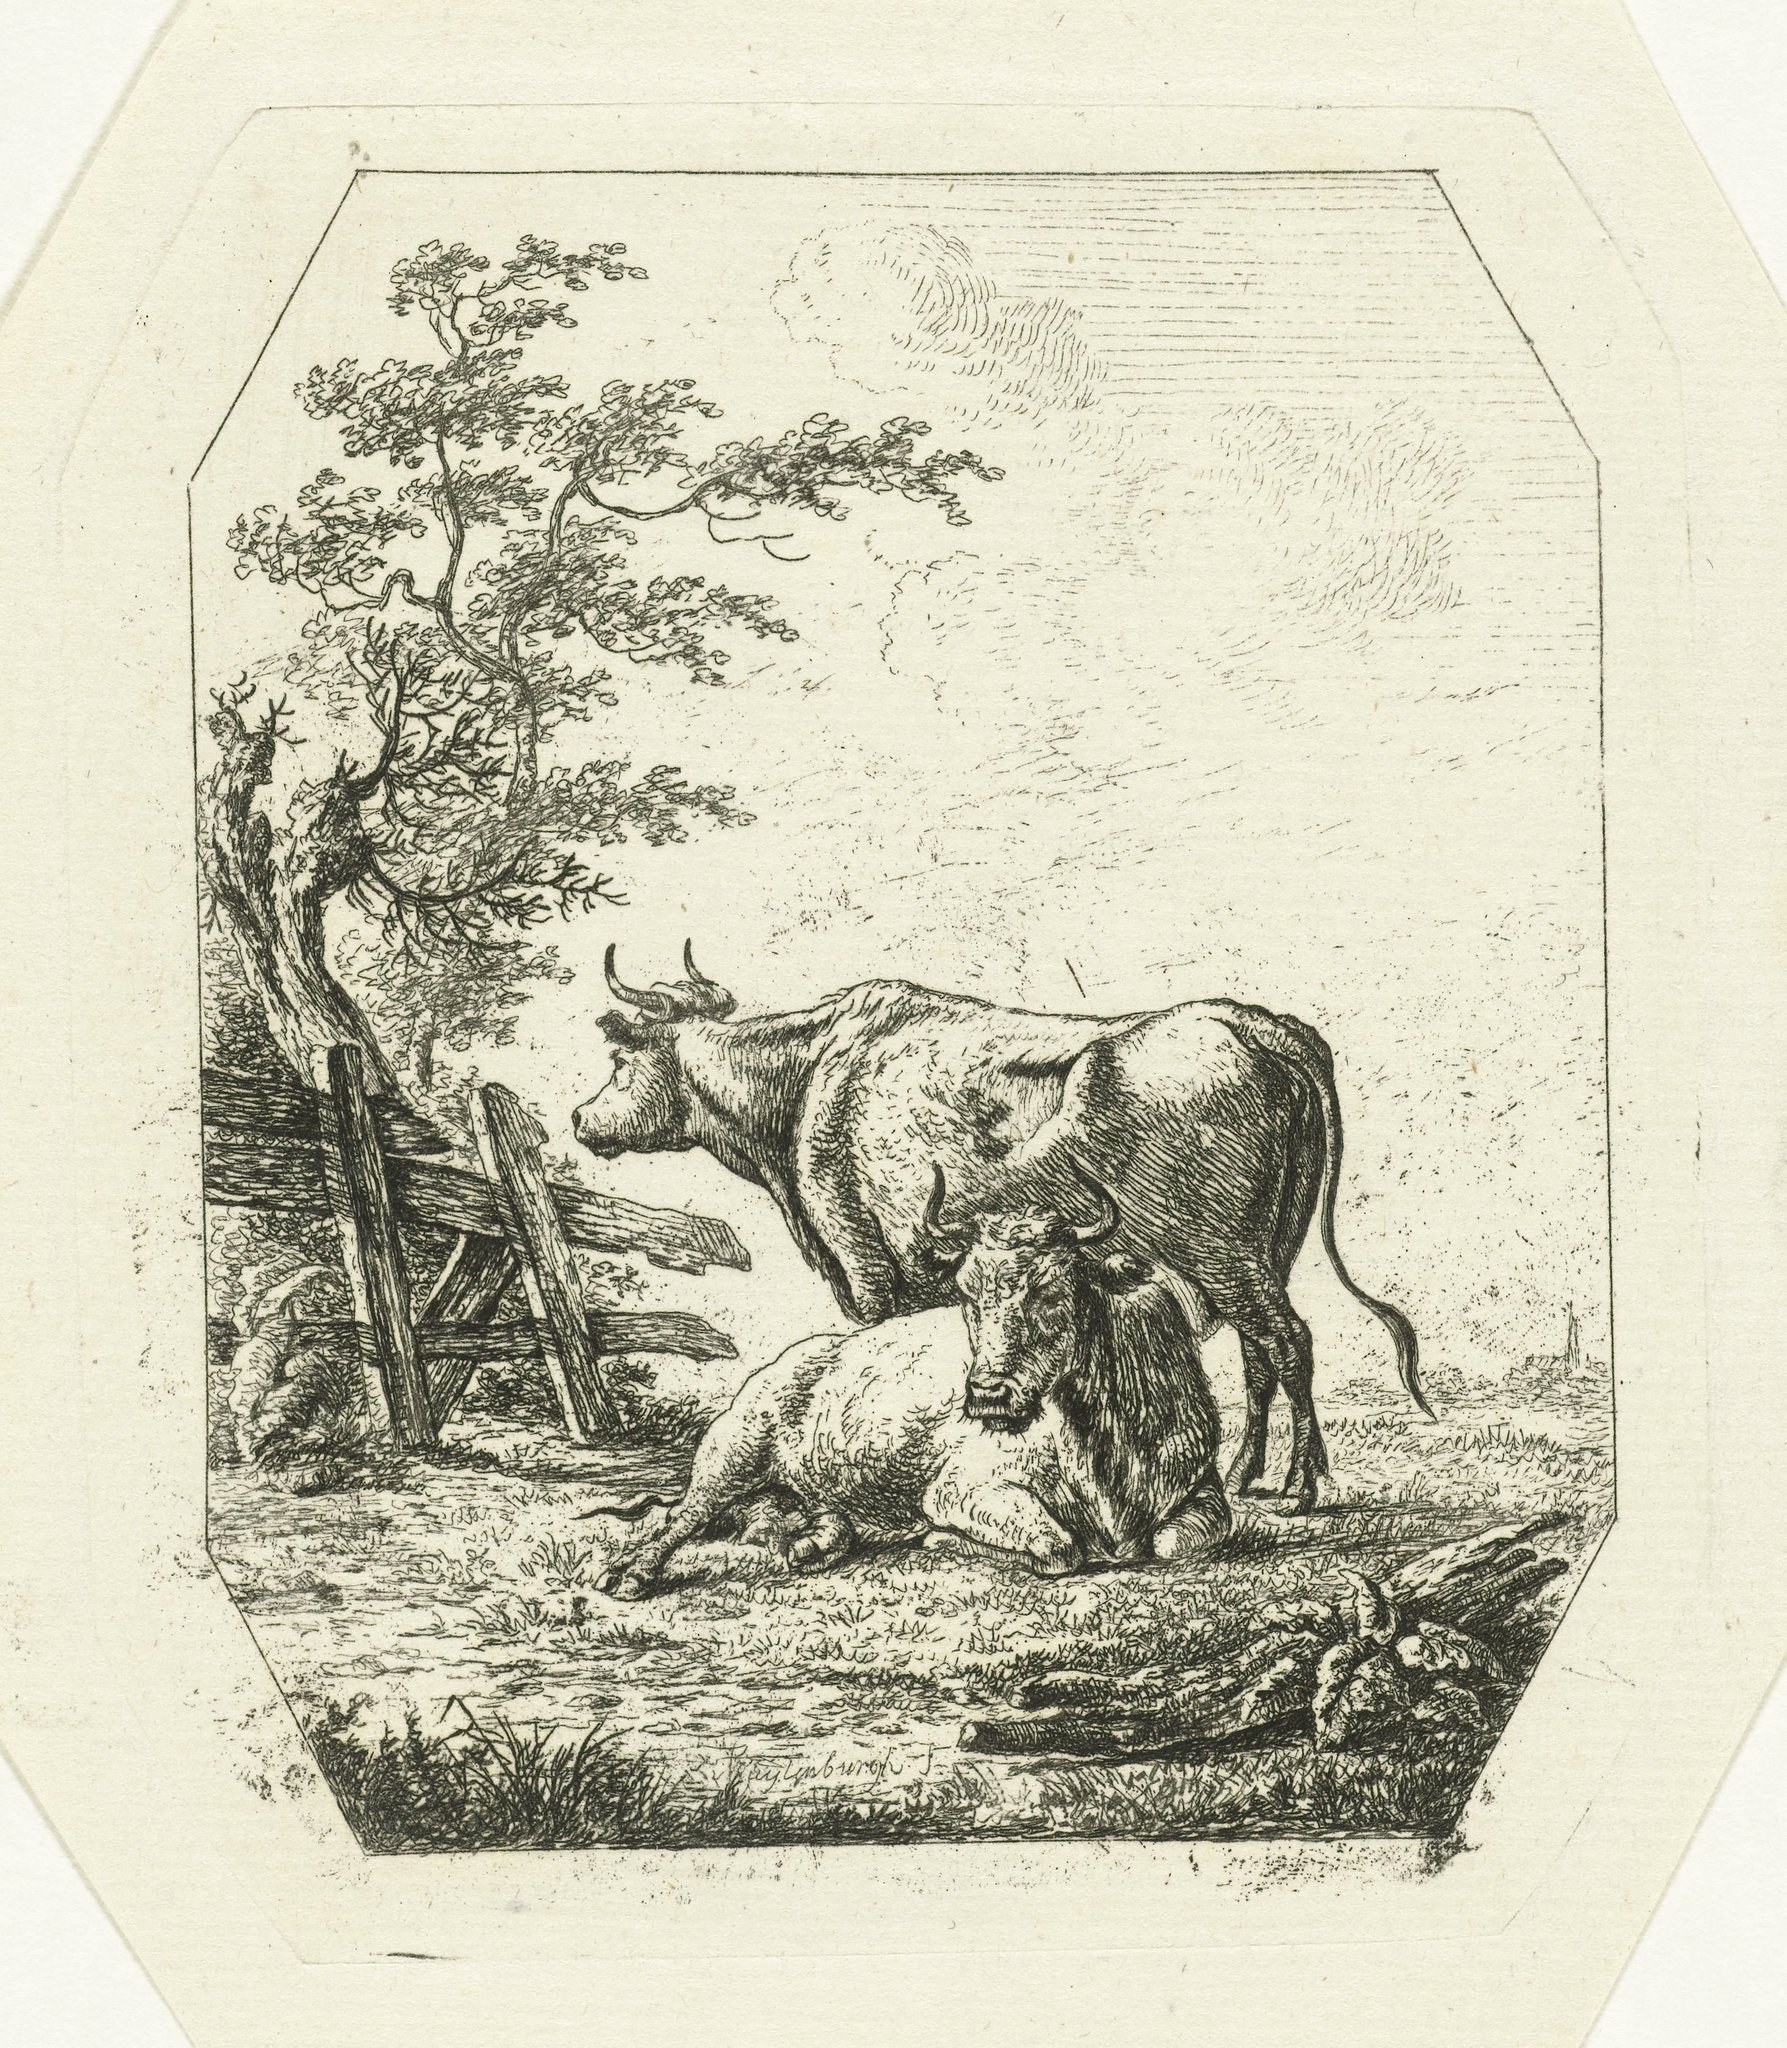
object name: print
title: Twee koeien bij een hek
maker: johannes van cuylenburgh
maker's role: print maker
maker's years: 1793-1841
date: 1803-1841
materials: paper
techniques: etching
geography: netherlands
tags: cow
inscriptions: collector's mark: Lugt 2228